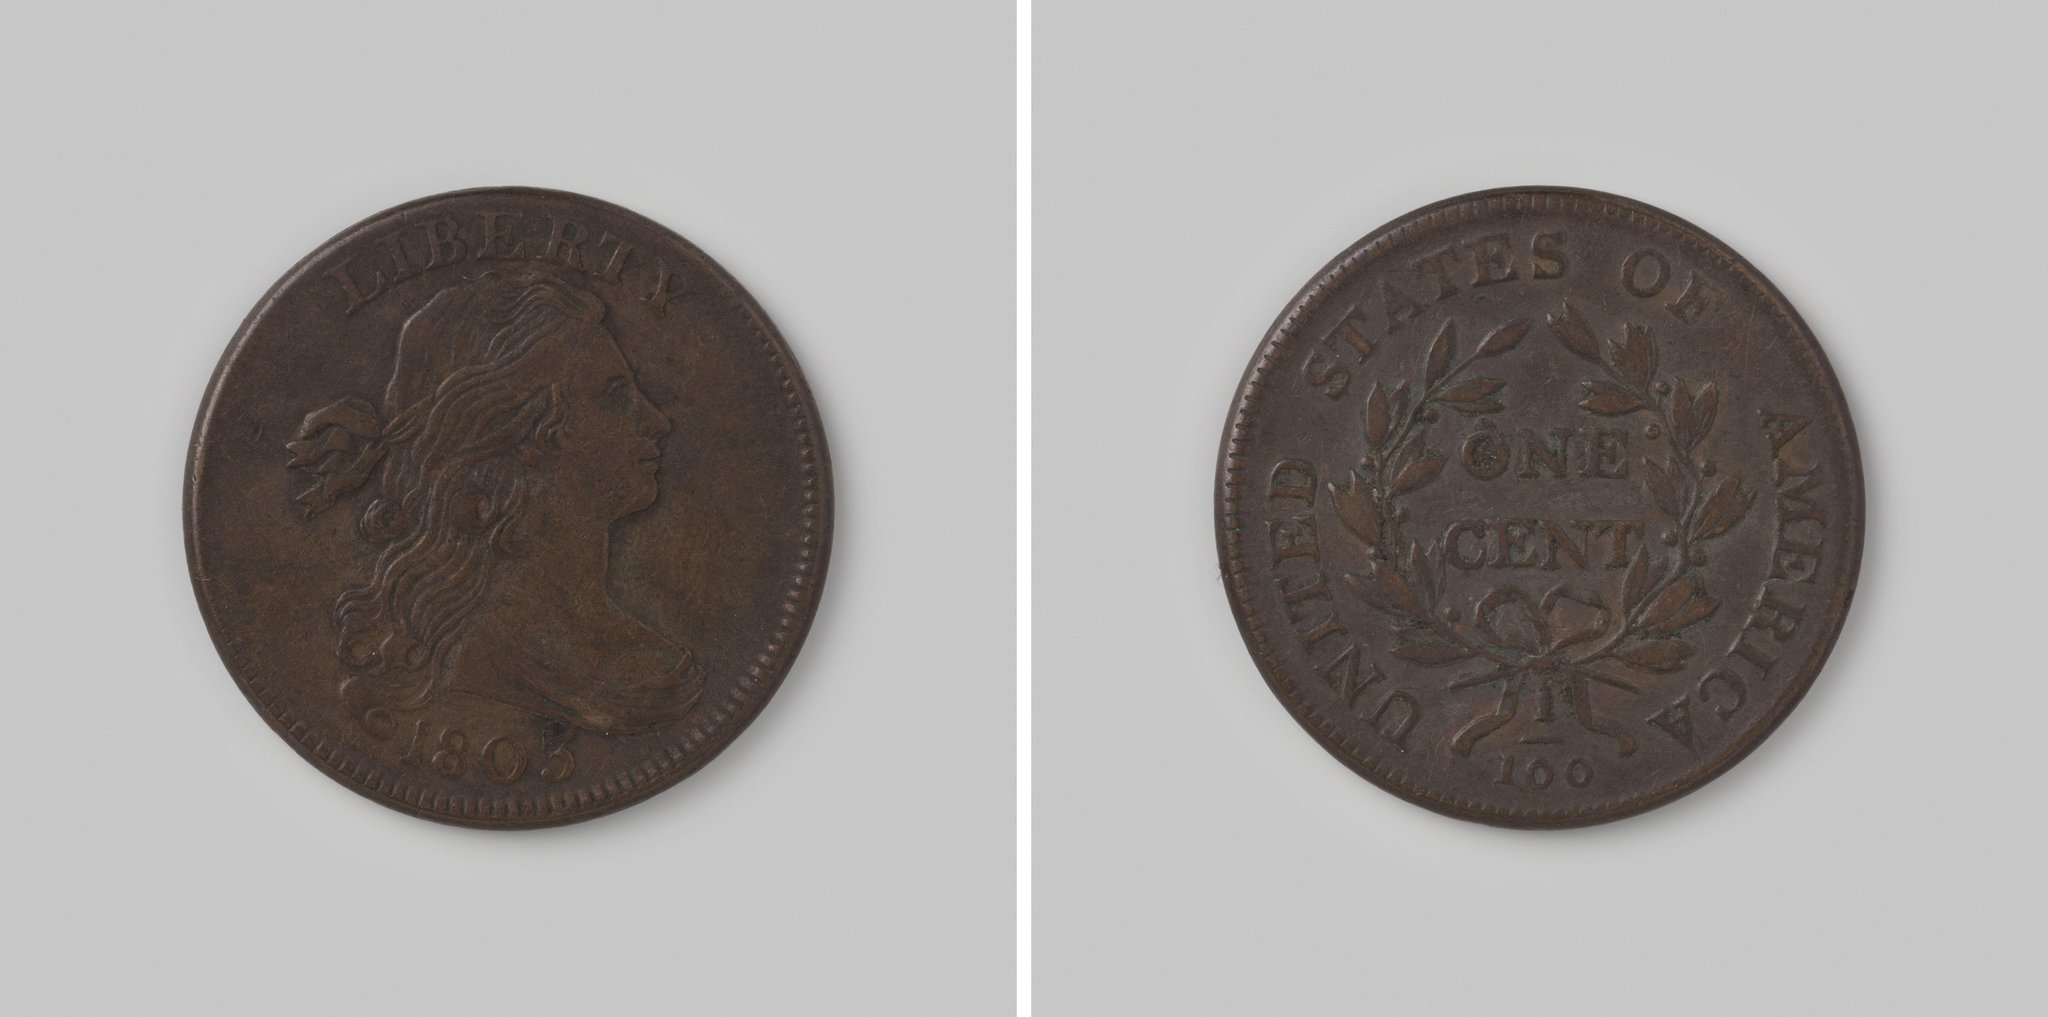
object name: coin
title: Verenigde Staten van Amerika, cent, 1803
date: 1803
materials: copper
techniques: striking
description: Koperen munt. Voorzijde: liberty (draped bust) naar rechts. Onderaan jaartal. Keerzijde: tussen twee met grote strik samengebonden takken waarde-aanduiding: one cent in twee regels. Onderaan tussen linten waarde-aanduiding: 1/100. Gladde rand.